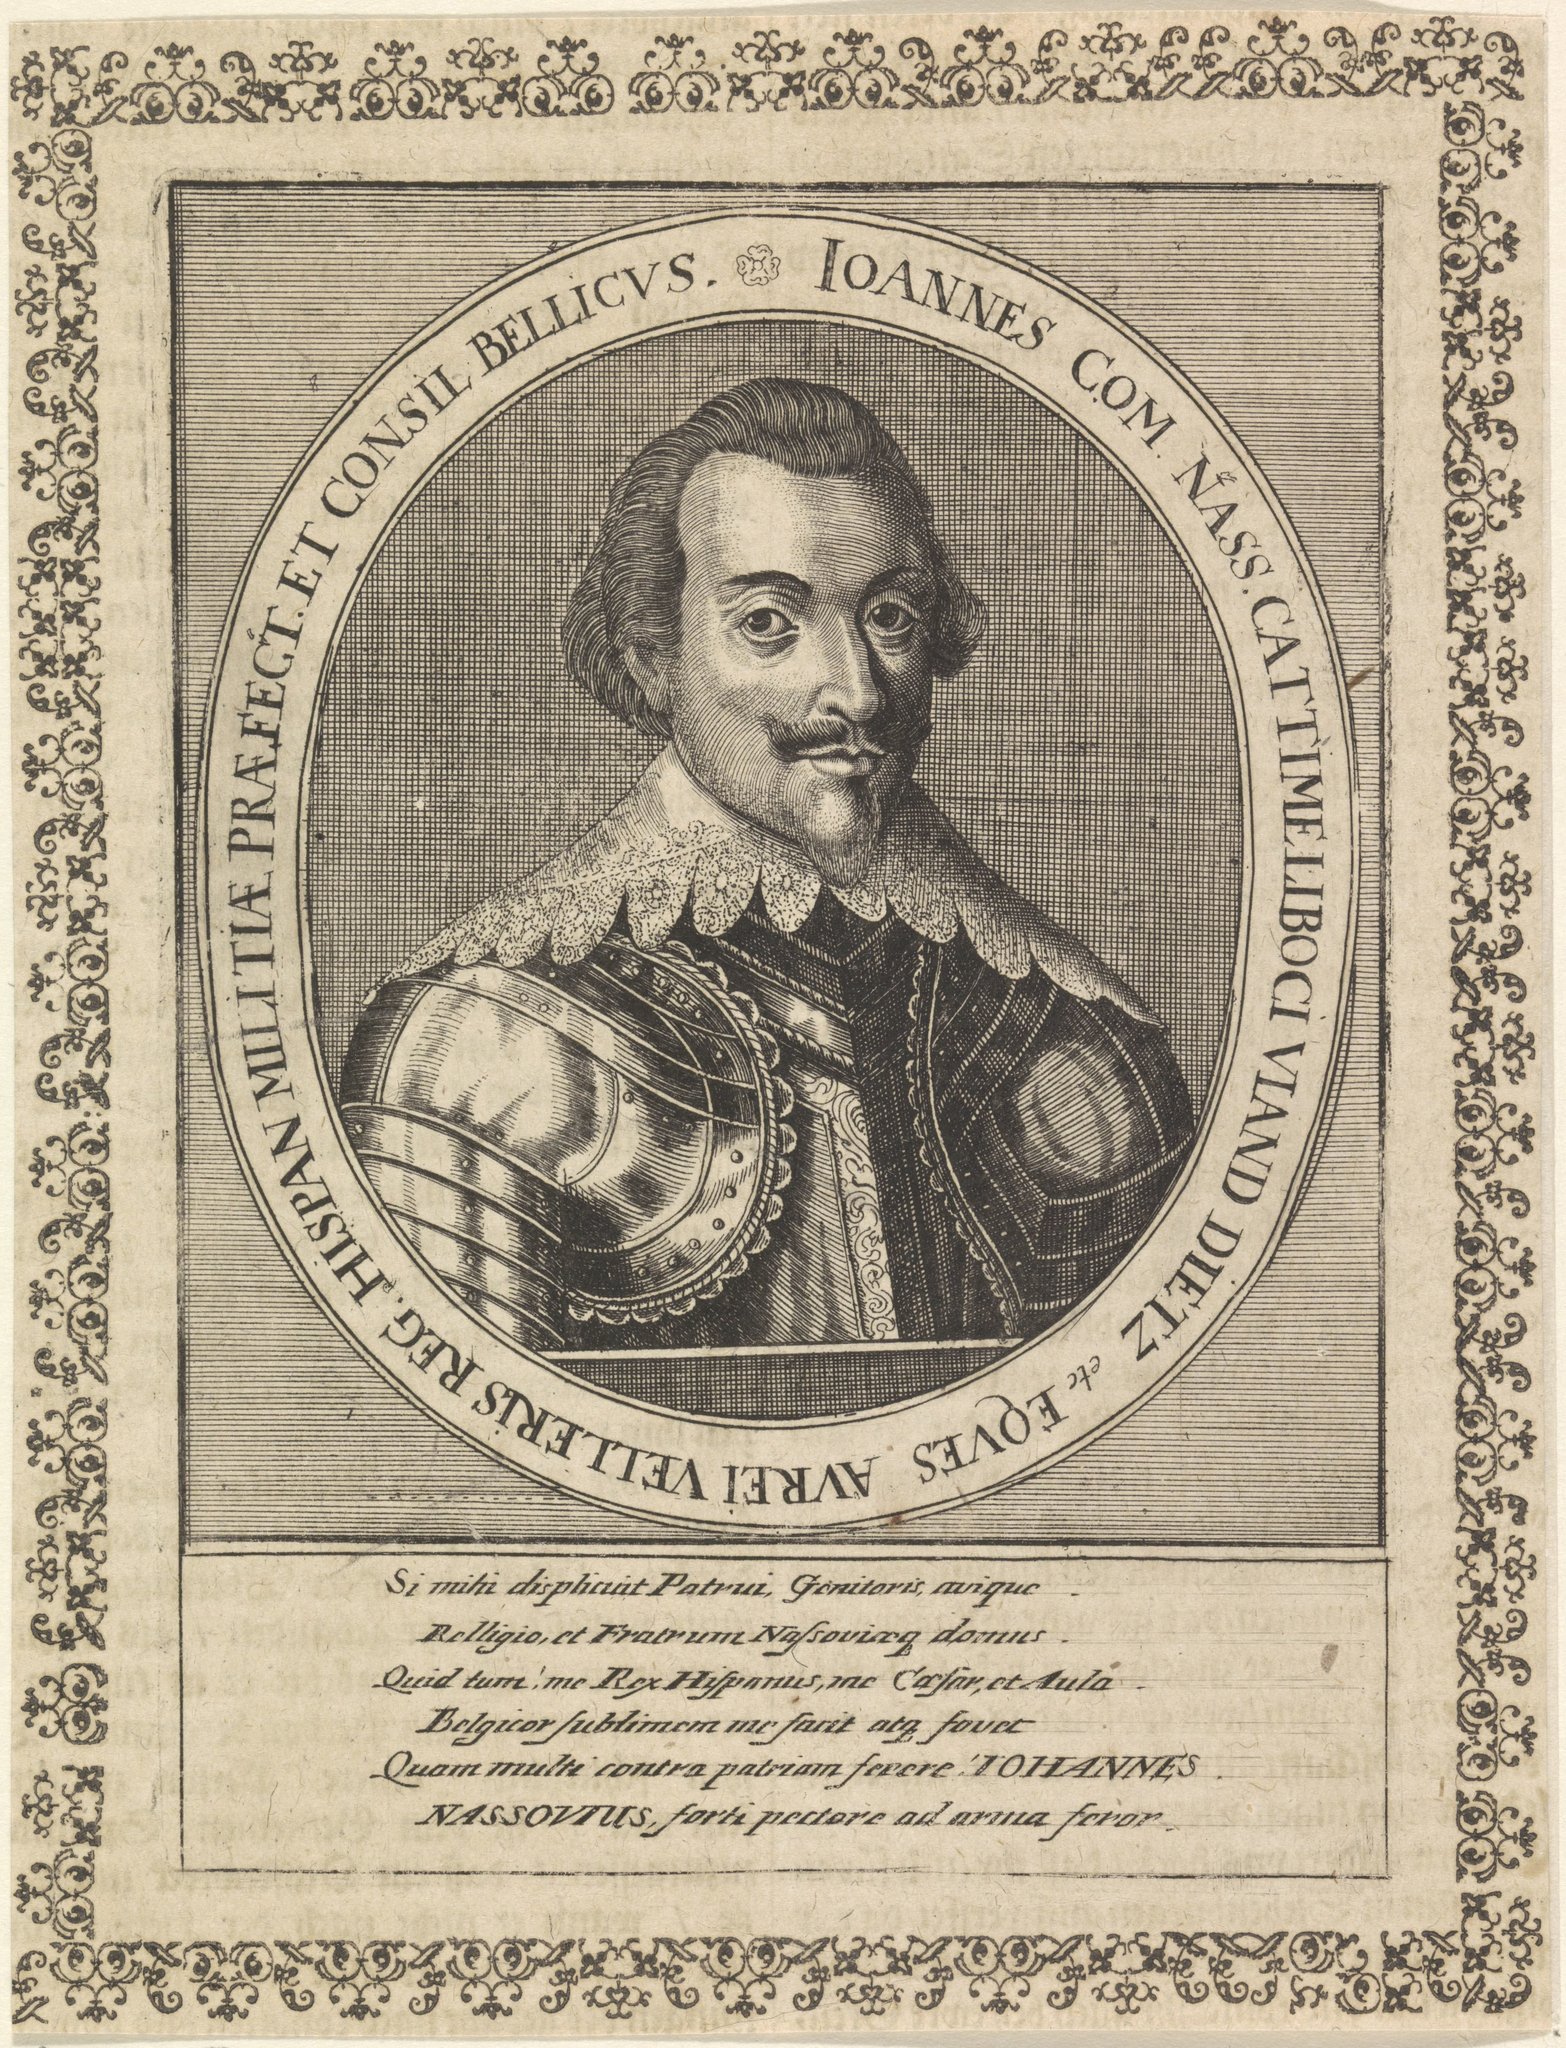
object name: book illustration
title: Portret van Johan VIII, graaf van Nassau-Siegen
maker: Anonymous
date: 1600-1699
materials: paper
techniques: engraving, etching, letterpress printing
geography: low countries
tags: dillenburg, renaix, johan viii graaf van nassau-siegen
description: De hier vermelde titel verwijst naar de hoogst verkregen titel van de geportretteerde, niet per se naar de titel die de geportretteerde op deze voorstelling draagt.